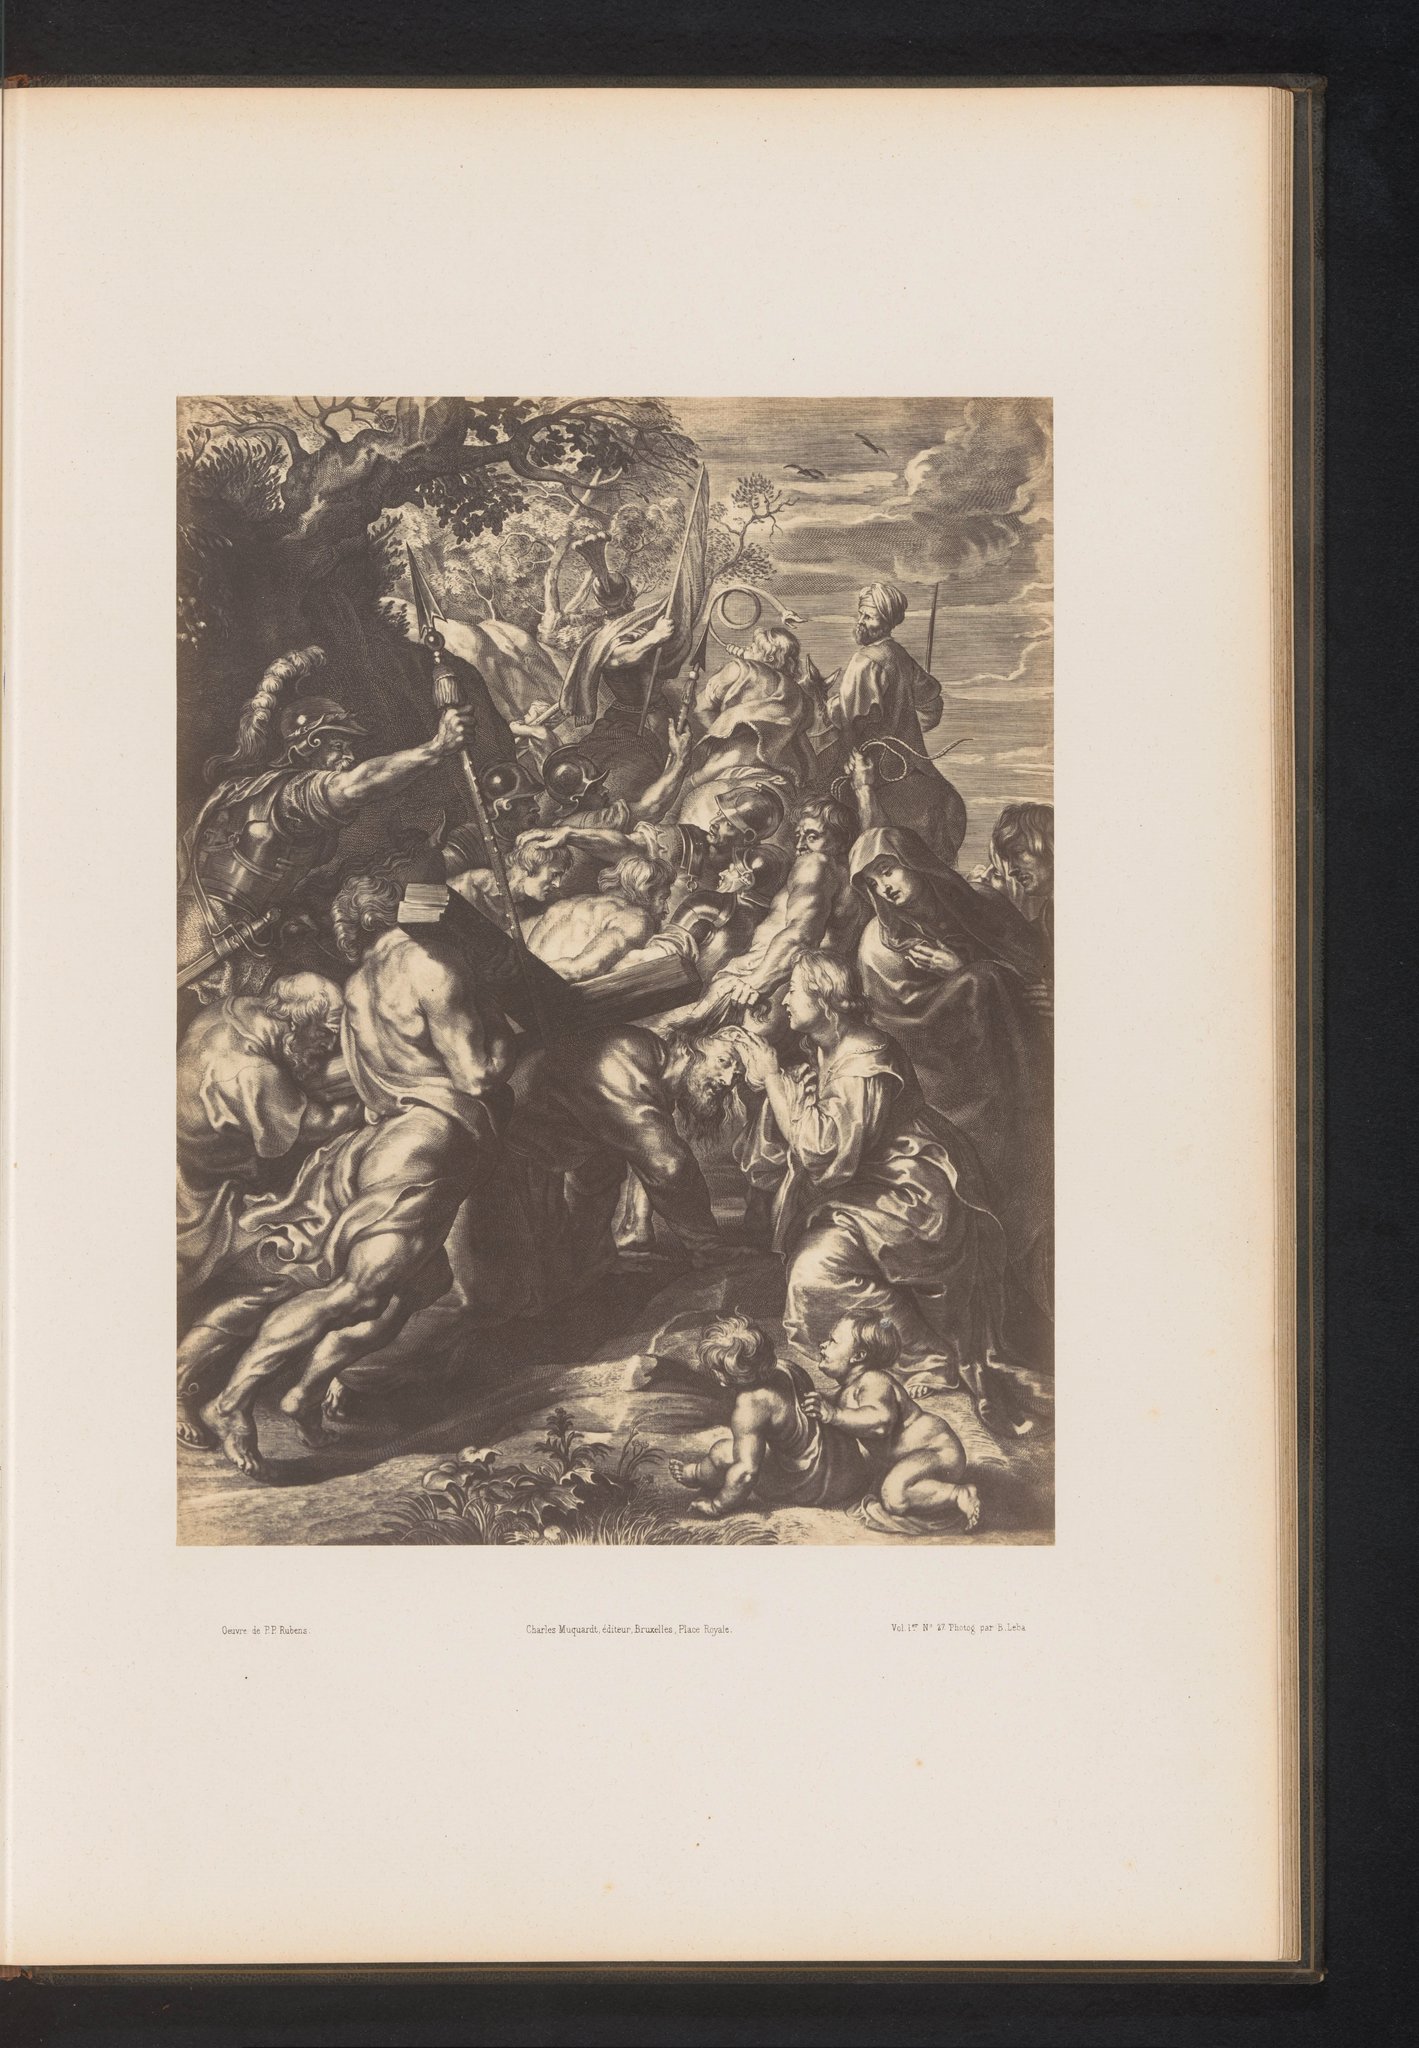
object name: page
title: Fotoreproductie van een gravure van De Kruisdraging door Paulus Pontius, naar het schilderij door Peter Paul Rubens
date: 1853-1858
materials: photographic support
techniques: albumen print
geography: brussels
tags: carrying of the cross: christ bearing the cross, alone or with the help of others (e.g. simon the cyrenian)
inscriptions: number: ‘Vol. 1er. No 27.’